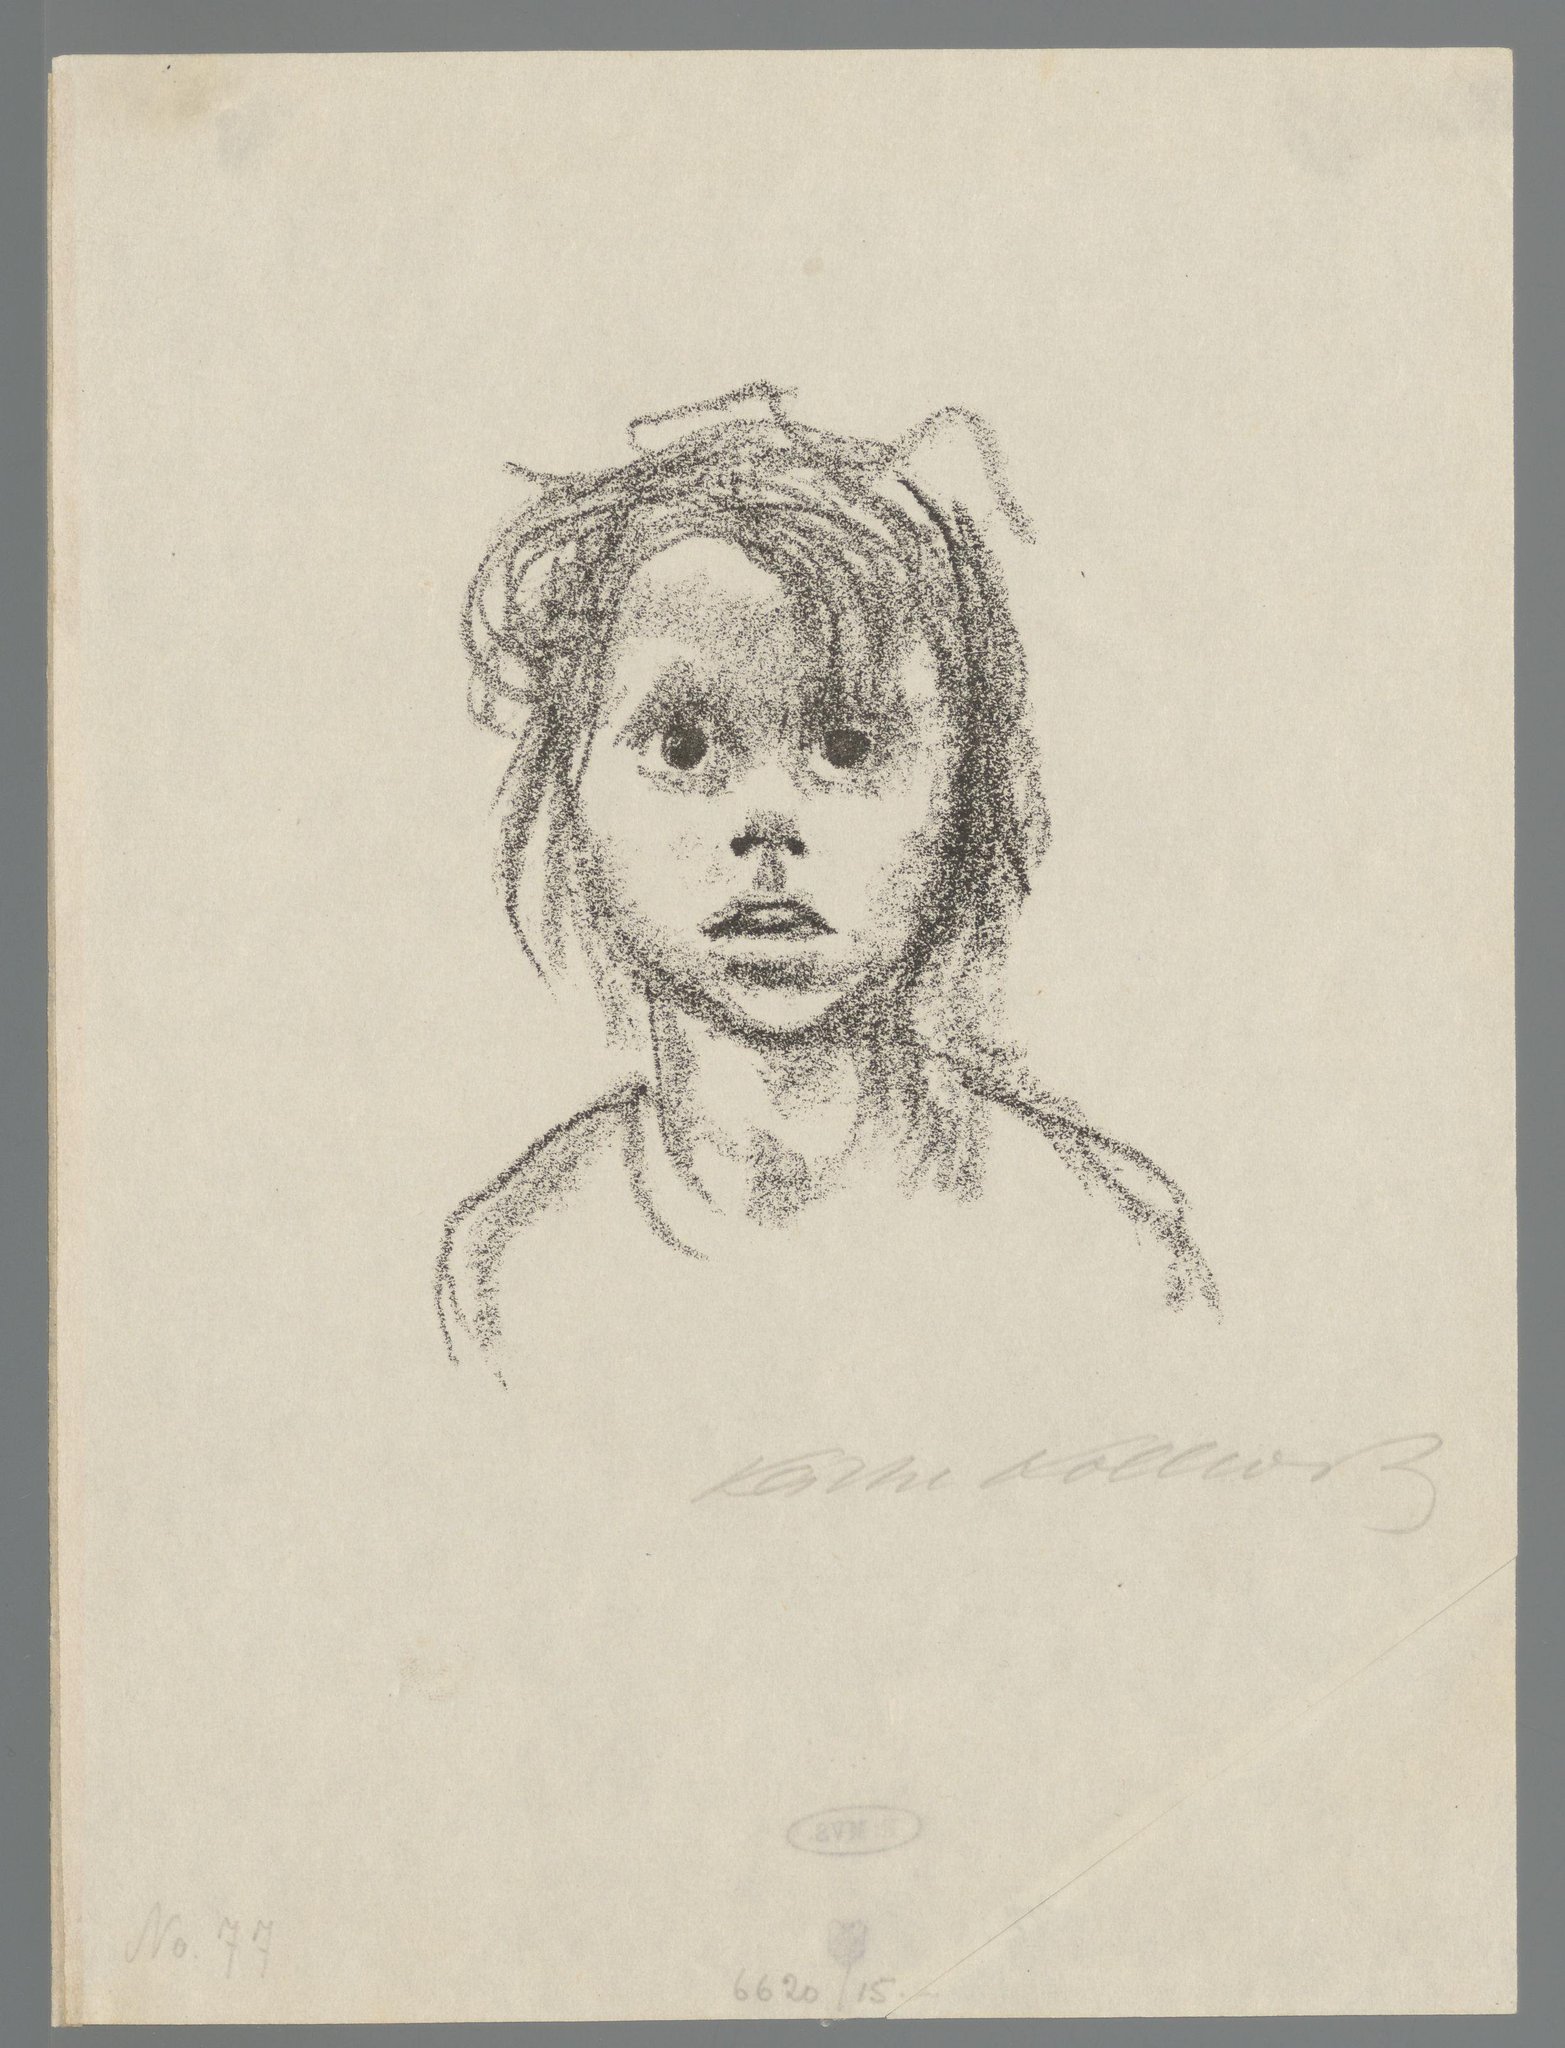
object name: print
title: Portret van een kind, waarschijnlijk Lotte Nagel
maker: käthe kollwitz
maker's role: draughtsman, print maker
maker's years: 1867-1945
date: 1925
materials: paper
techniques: lithograph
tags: child, historical persons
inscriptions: inscription: ‘No. 77; 6620/15’, collector's mark: Lugt 2228, collector's mark: Lugt 2760